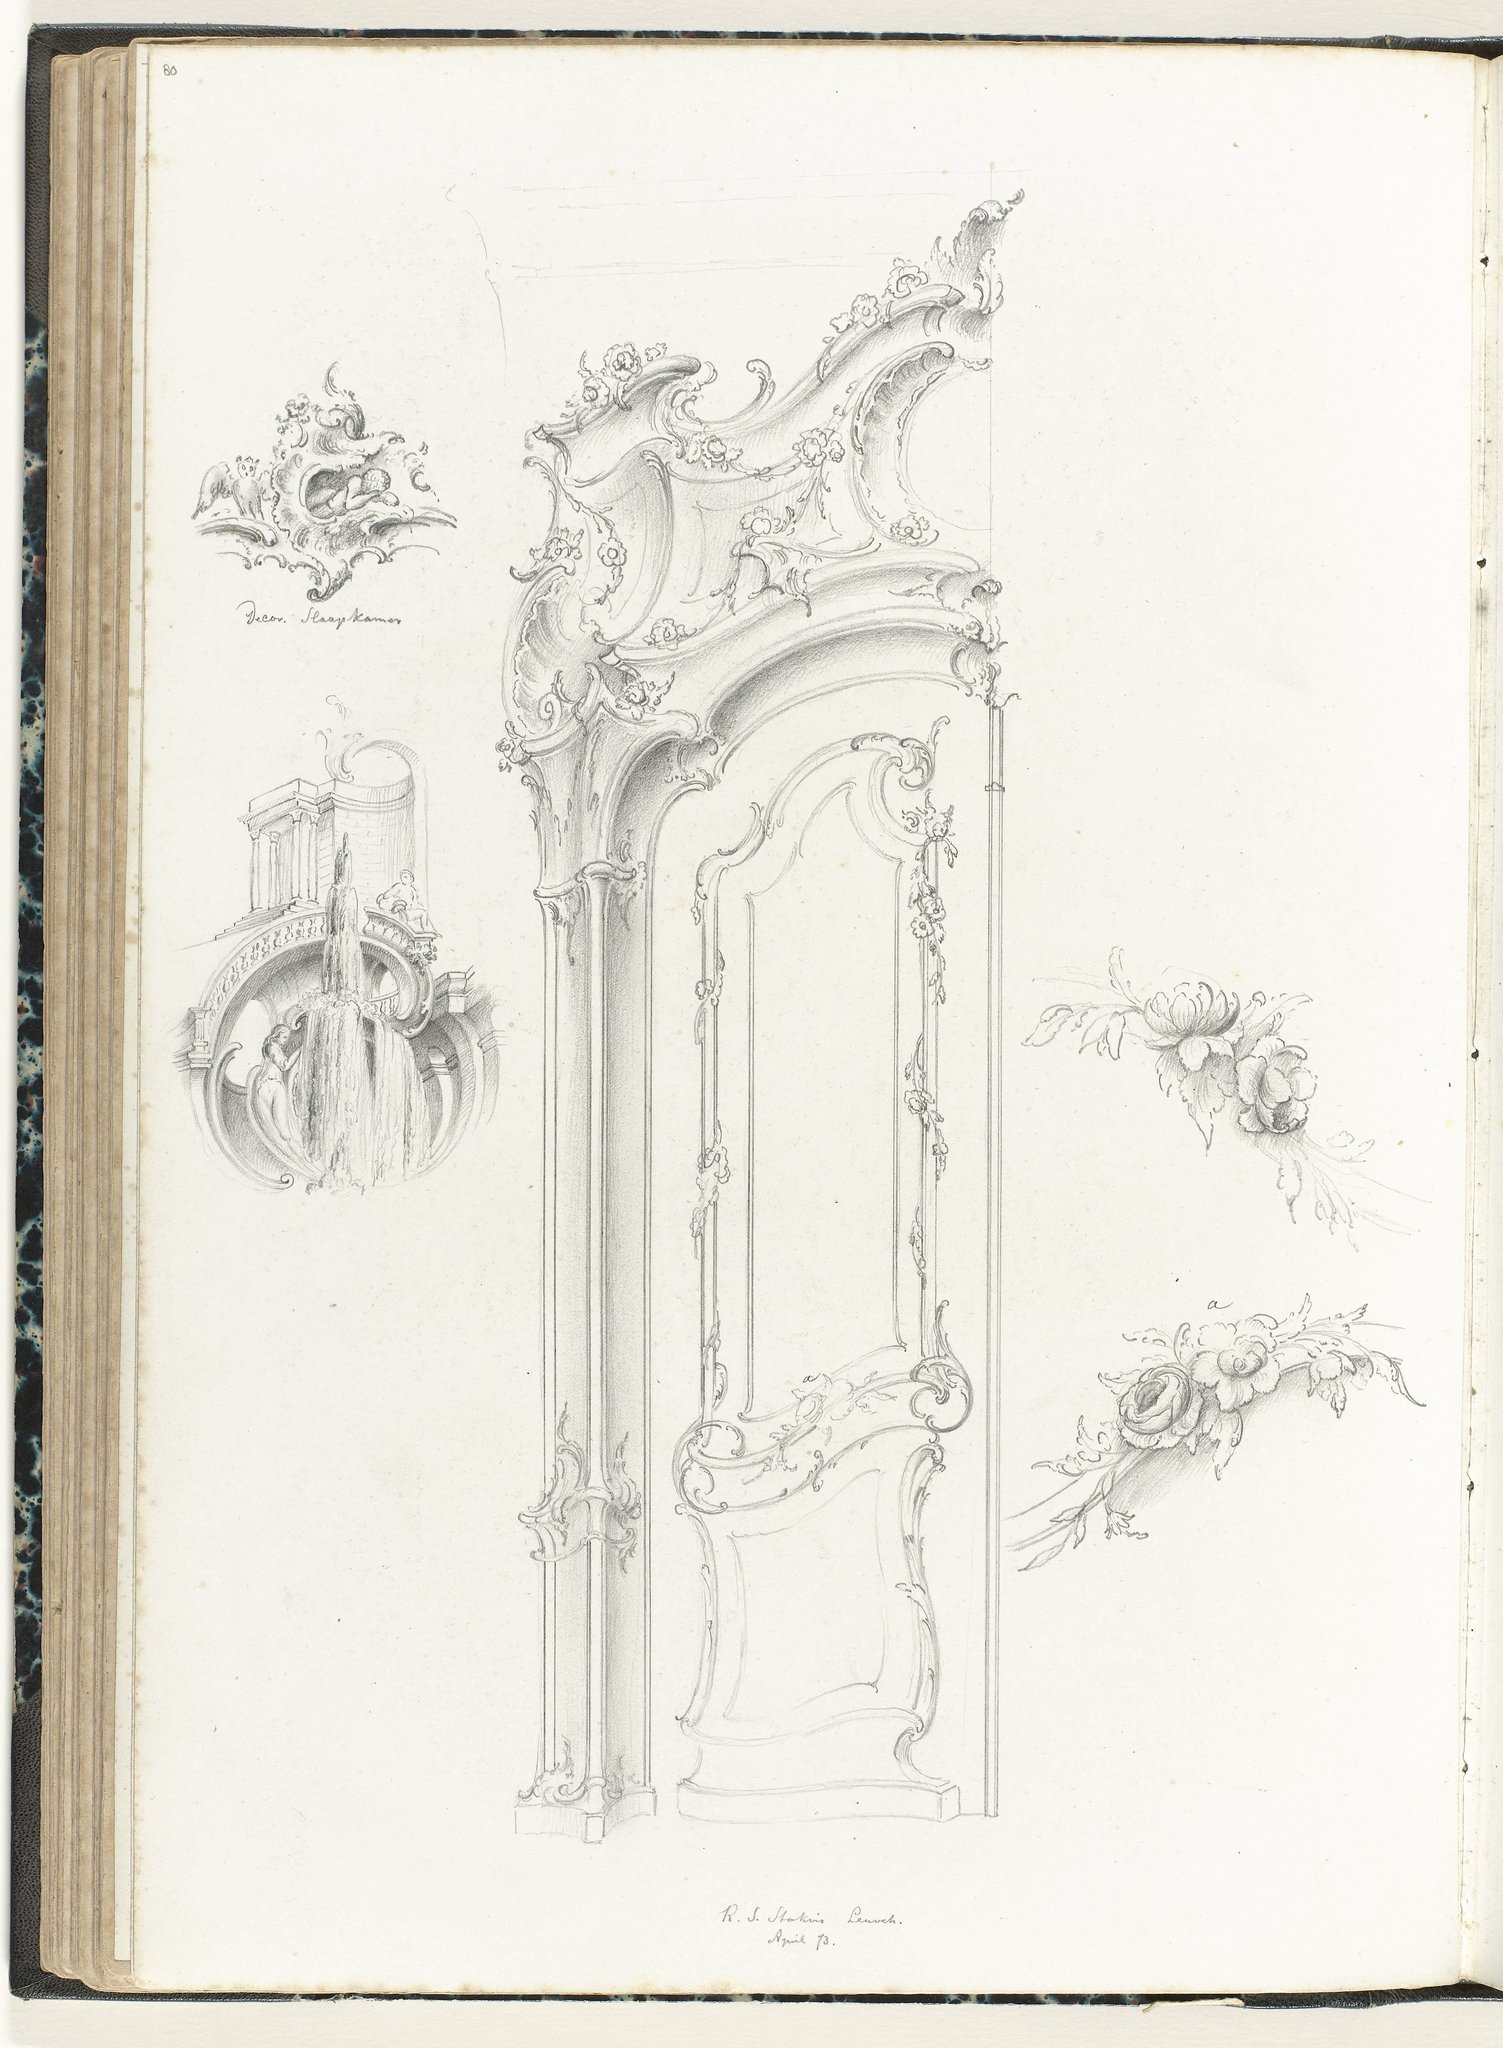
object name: drawing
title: Deur(?), fontein en drie details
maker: Anonymous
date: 1866-1900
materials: paper, pencil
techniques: drawing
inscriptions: annotation: ‘R.S. Stokvis Leuveh. April 73.’, annotation: ‘Decor. Slaapkamer’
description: In het midden is een deur te zien in een omlijsting met bovenaan een cartouche, links een fontein met op de achtergrond een gebouw.